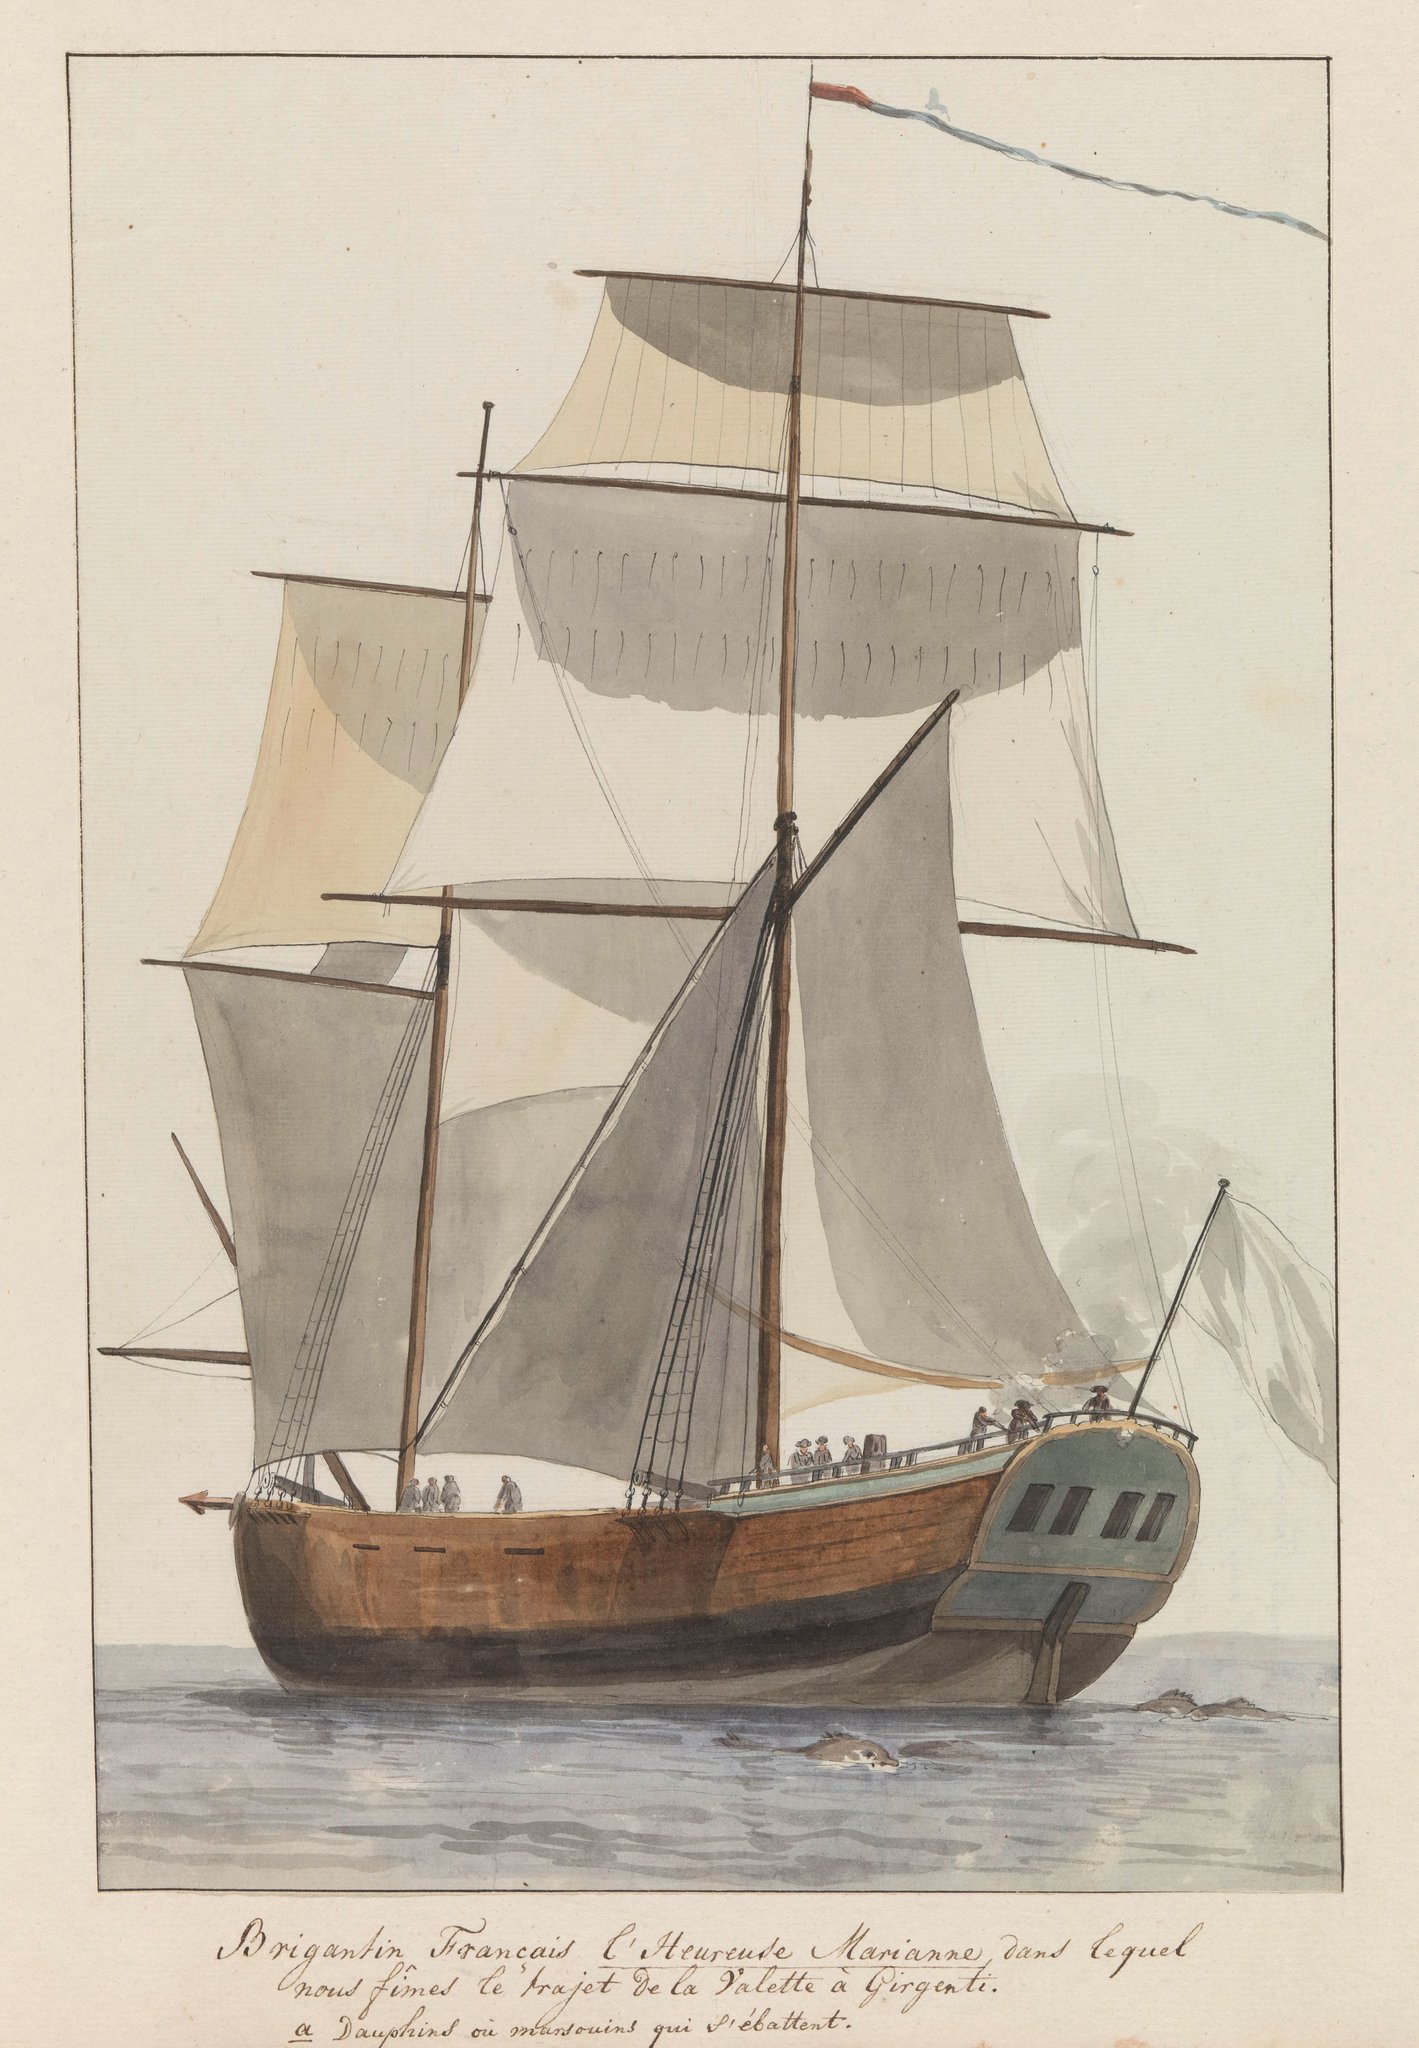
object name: watercolor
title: Frans brigantijn schip l'Heureuse Marianne waarop het reisgezelschap van Valette naar Agrigento vaarde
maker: louis ducros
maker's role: draughtsman, print maker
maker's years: 1748-1810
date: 1778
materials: chalk, paper, watercolor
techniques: brush, pen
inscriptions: inscription: ‘No 237 Brigantin Francais l'Heureuse Marianne, dans lequel nous fîmes le traject de la Valette à Girgenti’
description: Tekening uit het album 'Voyage en Italie, en Sicile et à Malte', 1778.